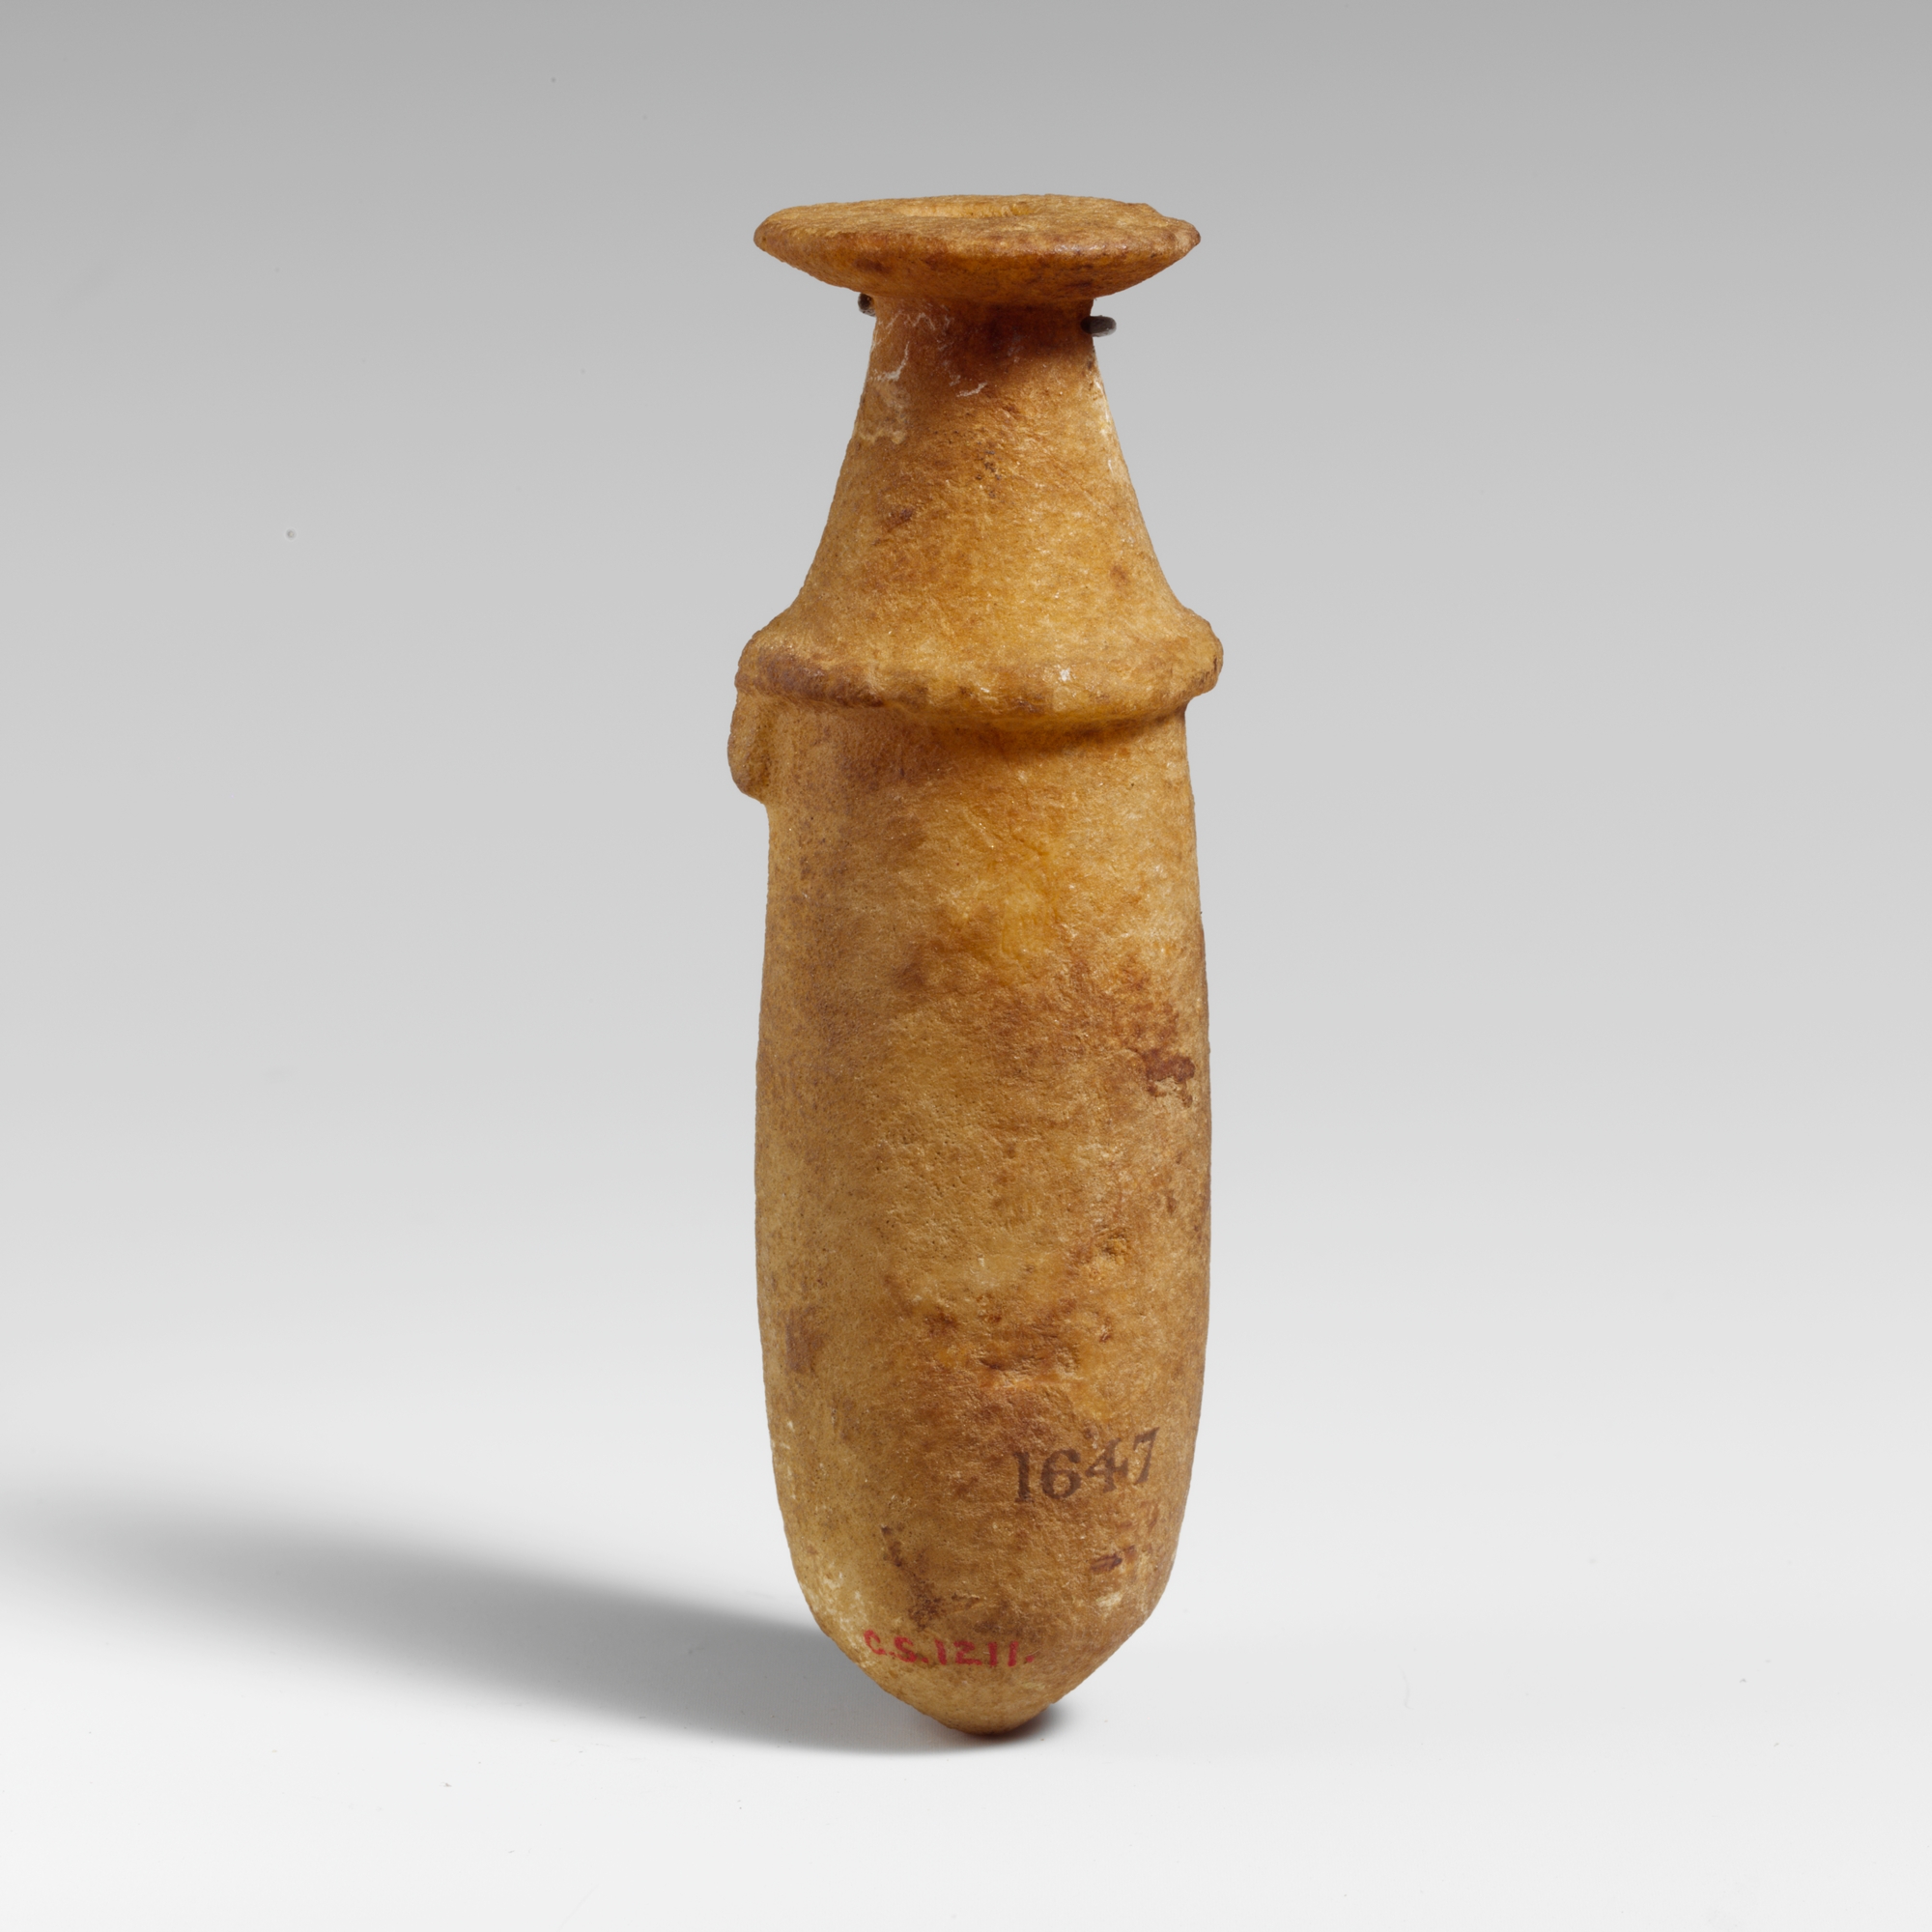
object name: vase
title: Alabaster alabastron (perfume vase)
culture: cypriot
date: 600-301 BCE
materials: gypsum